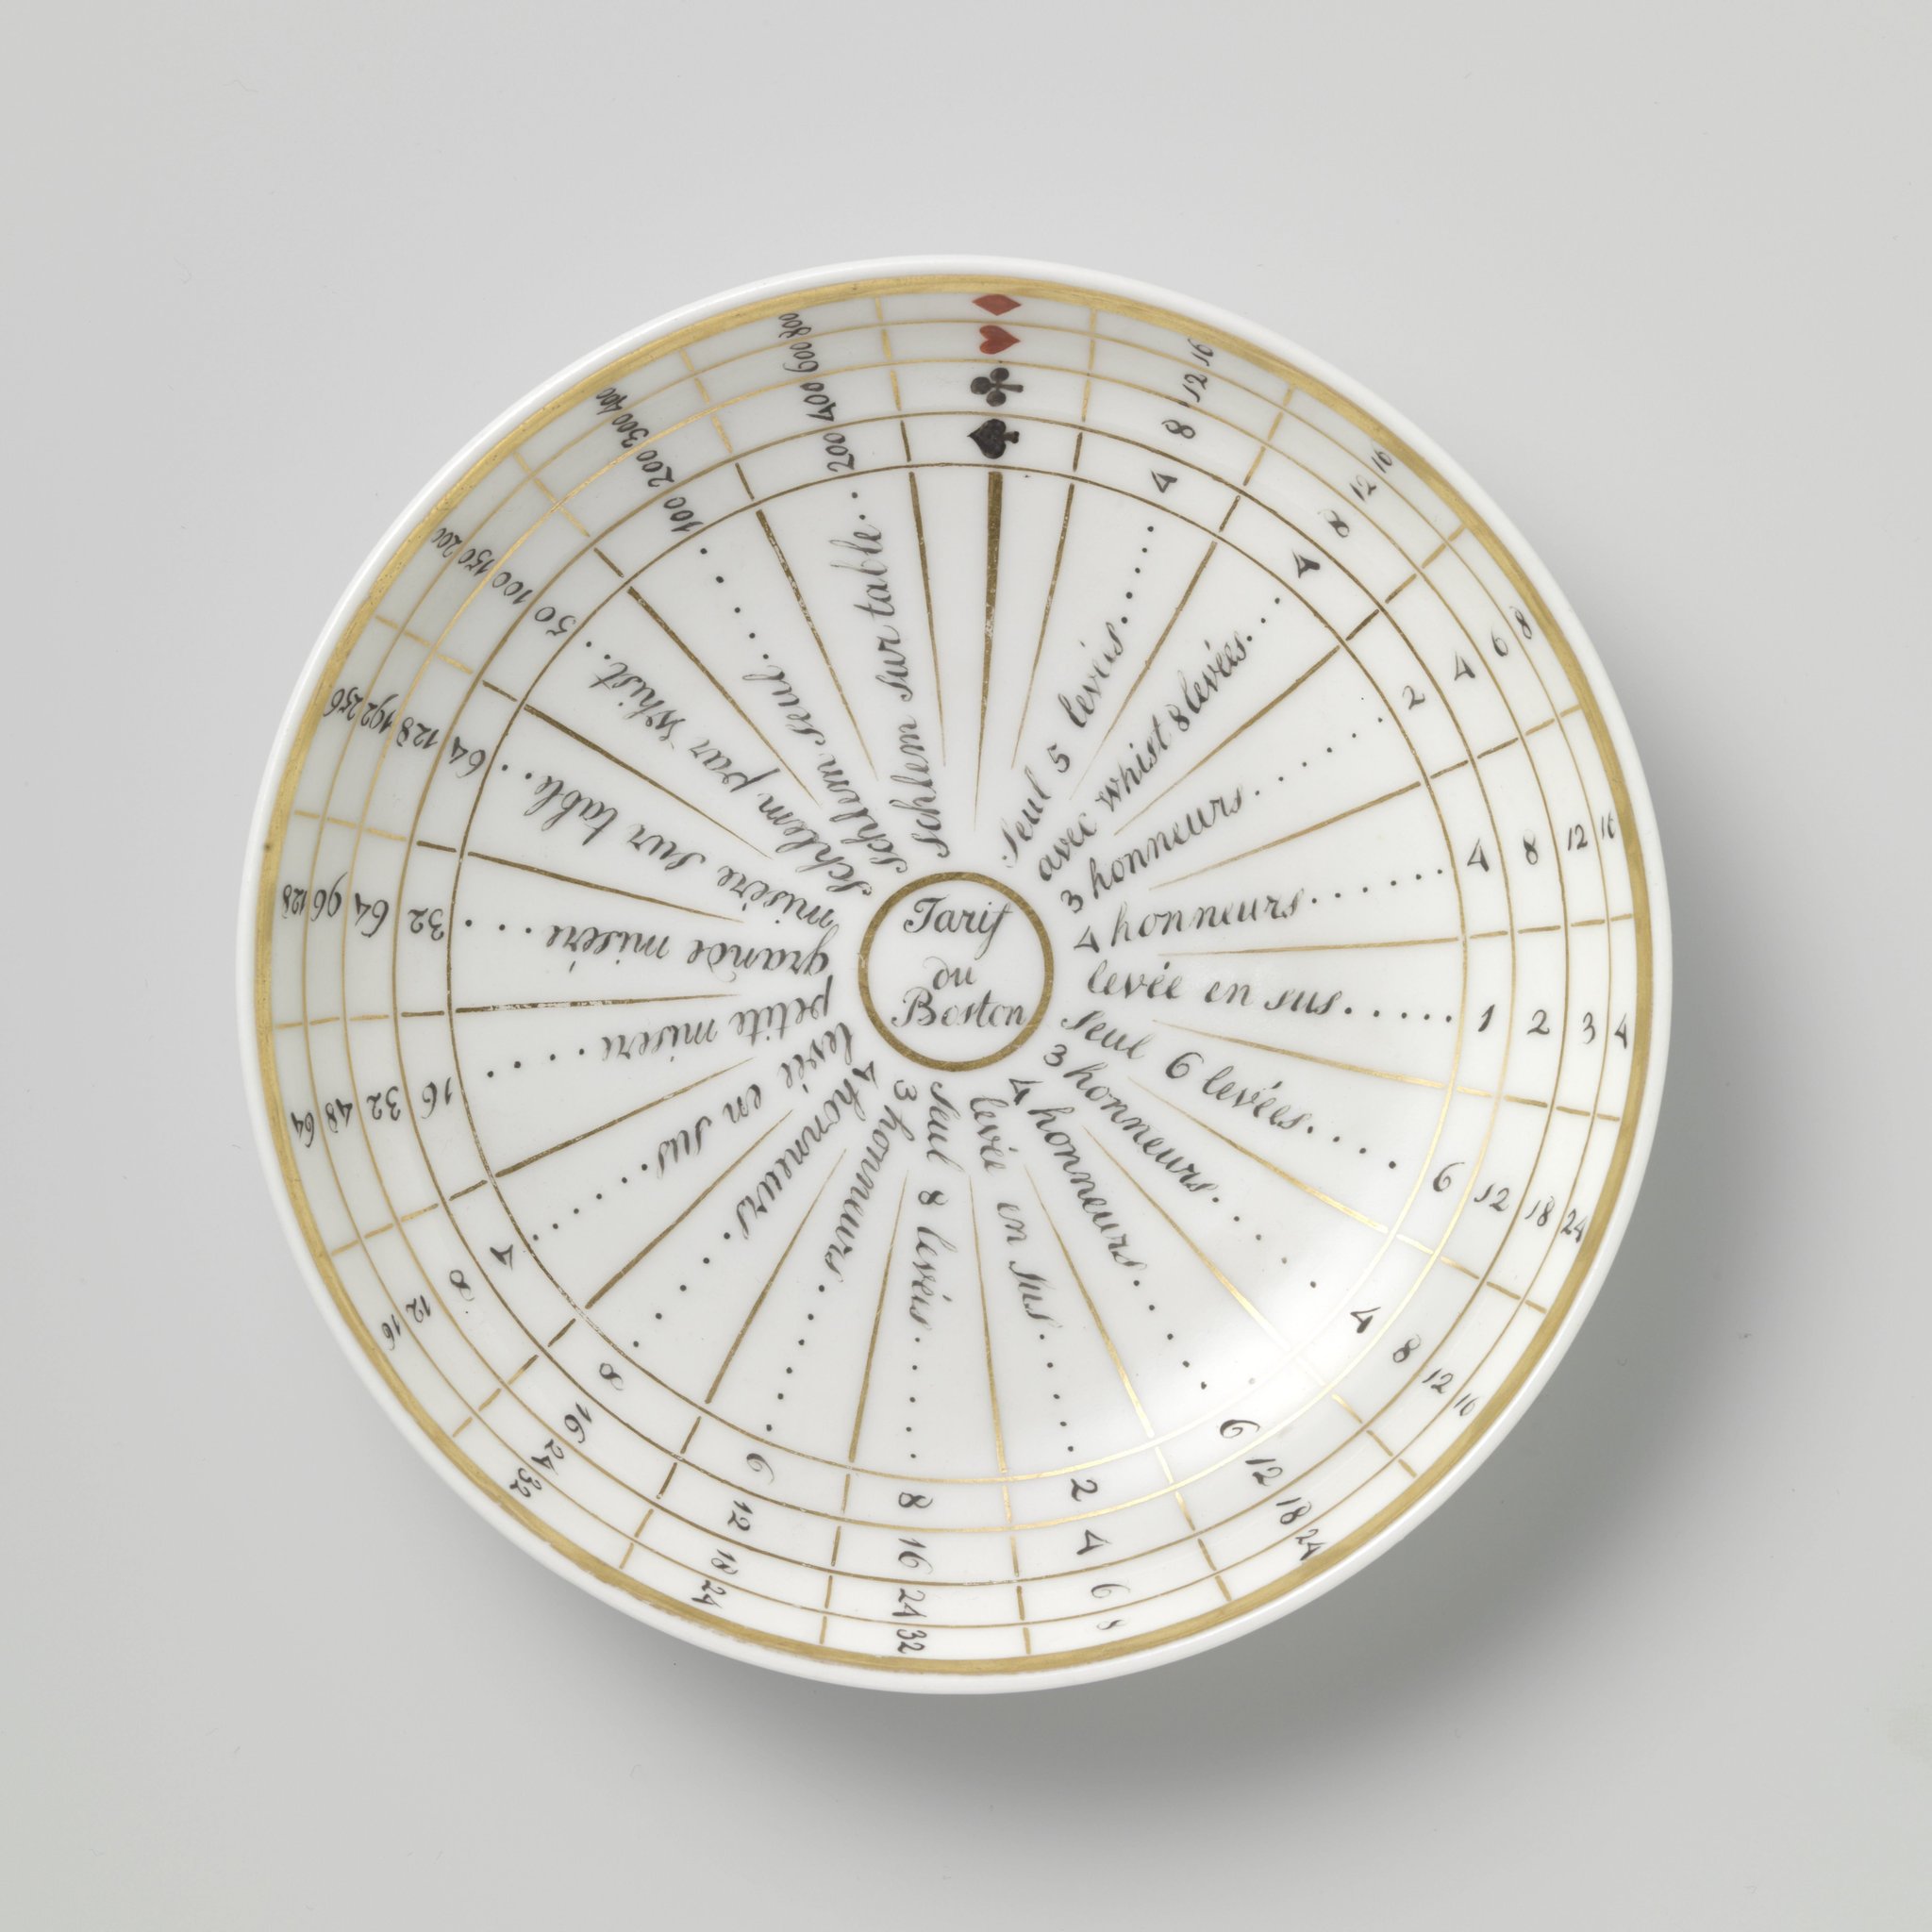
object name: platter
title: Saucer with the score card of a cardgame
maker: Anonymous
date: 1800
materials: glaze, gold, paint, porcelain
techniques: firing, gilding, turning, vitrification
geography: paris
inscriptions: mark: ‘vier stippen’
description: Schotel van porselein, beschilderd op het glazuur met rood, zwart en goud. Op het plat een medaillon met het opschrift 'Tarif du Boston'. Hieromheen uitstralende vakken, doorlopend op de wand, met de tarievenkaart van het kaartspel Jeu de Boston Russe. Gemerkt met vier gouden stippen op de onderzijde.